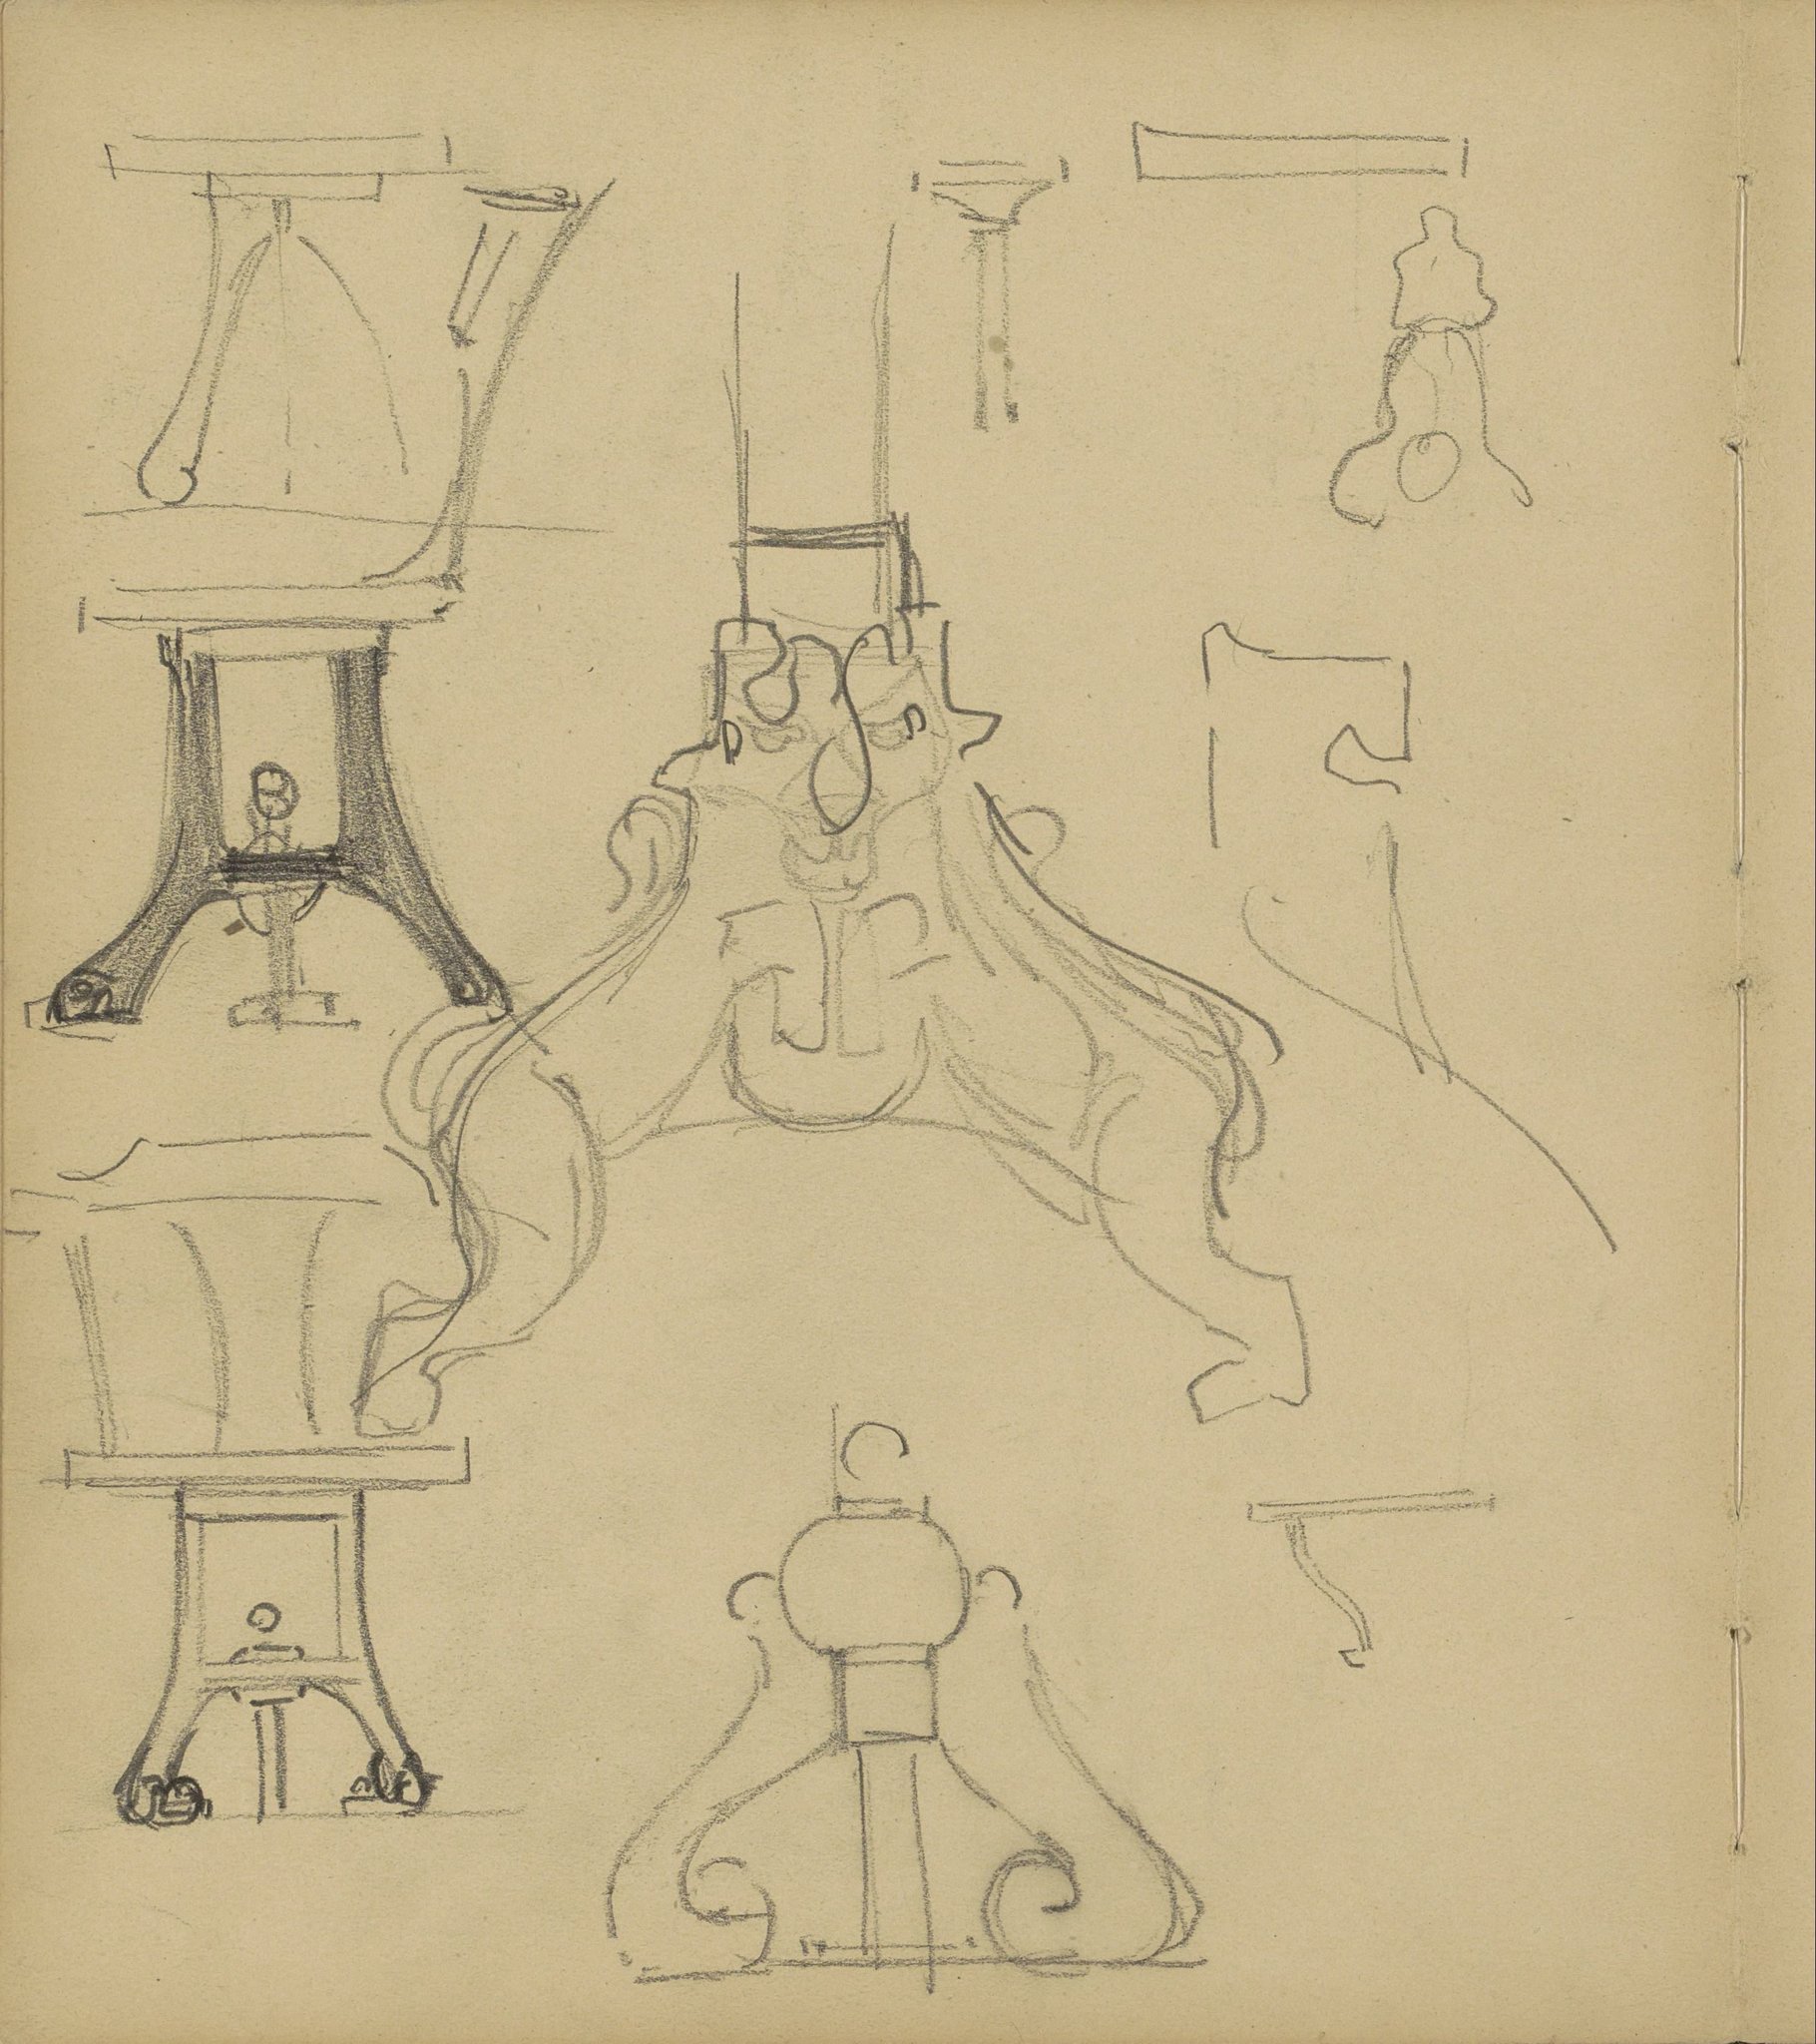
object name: sketchbook leaf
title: Ontwerpen voor het onderstel van een tafel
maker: carel adolph lion cachet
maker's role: draughtsman, print maker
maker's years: 1864-1945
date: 1906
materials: paper, pencil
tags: table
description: Blad 22 verso uit een schetsboek met 27 bladen.